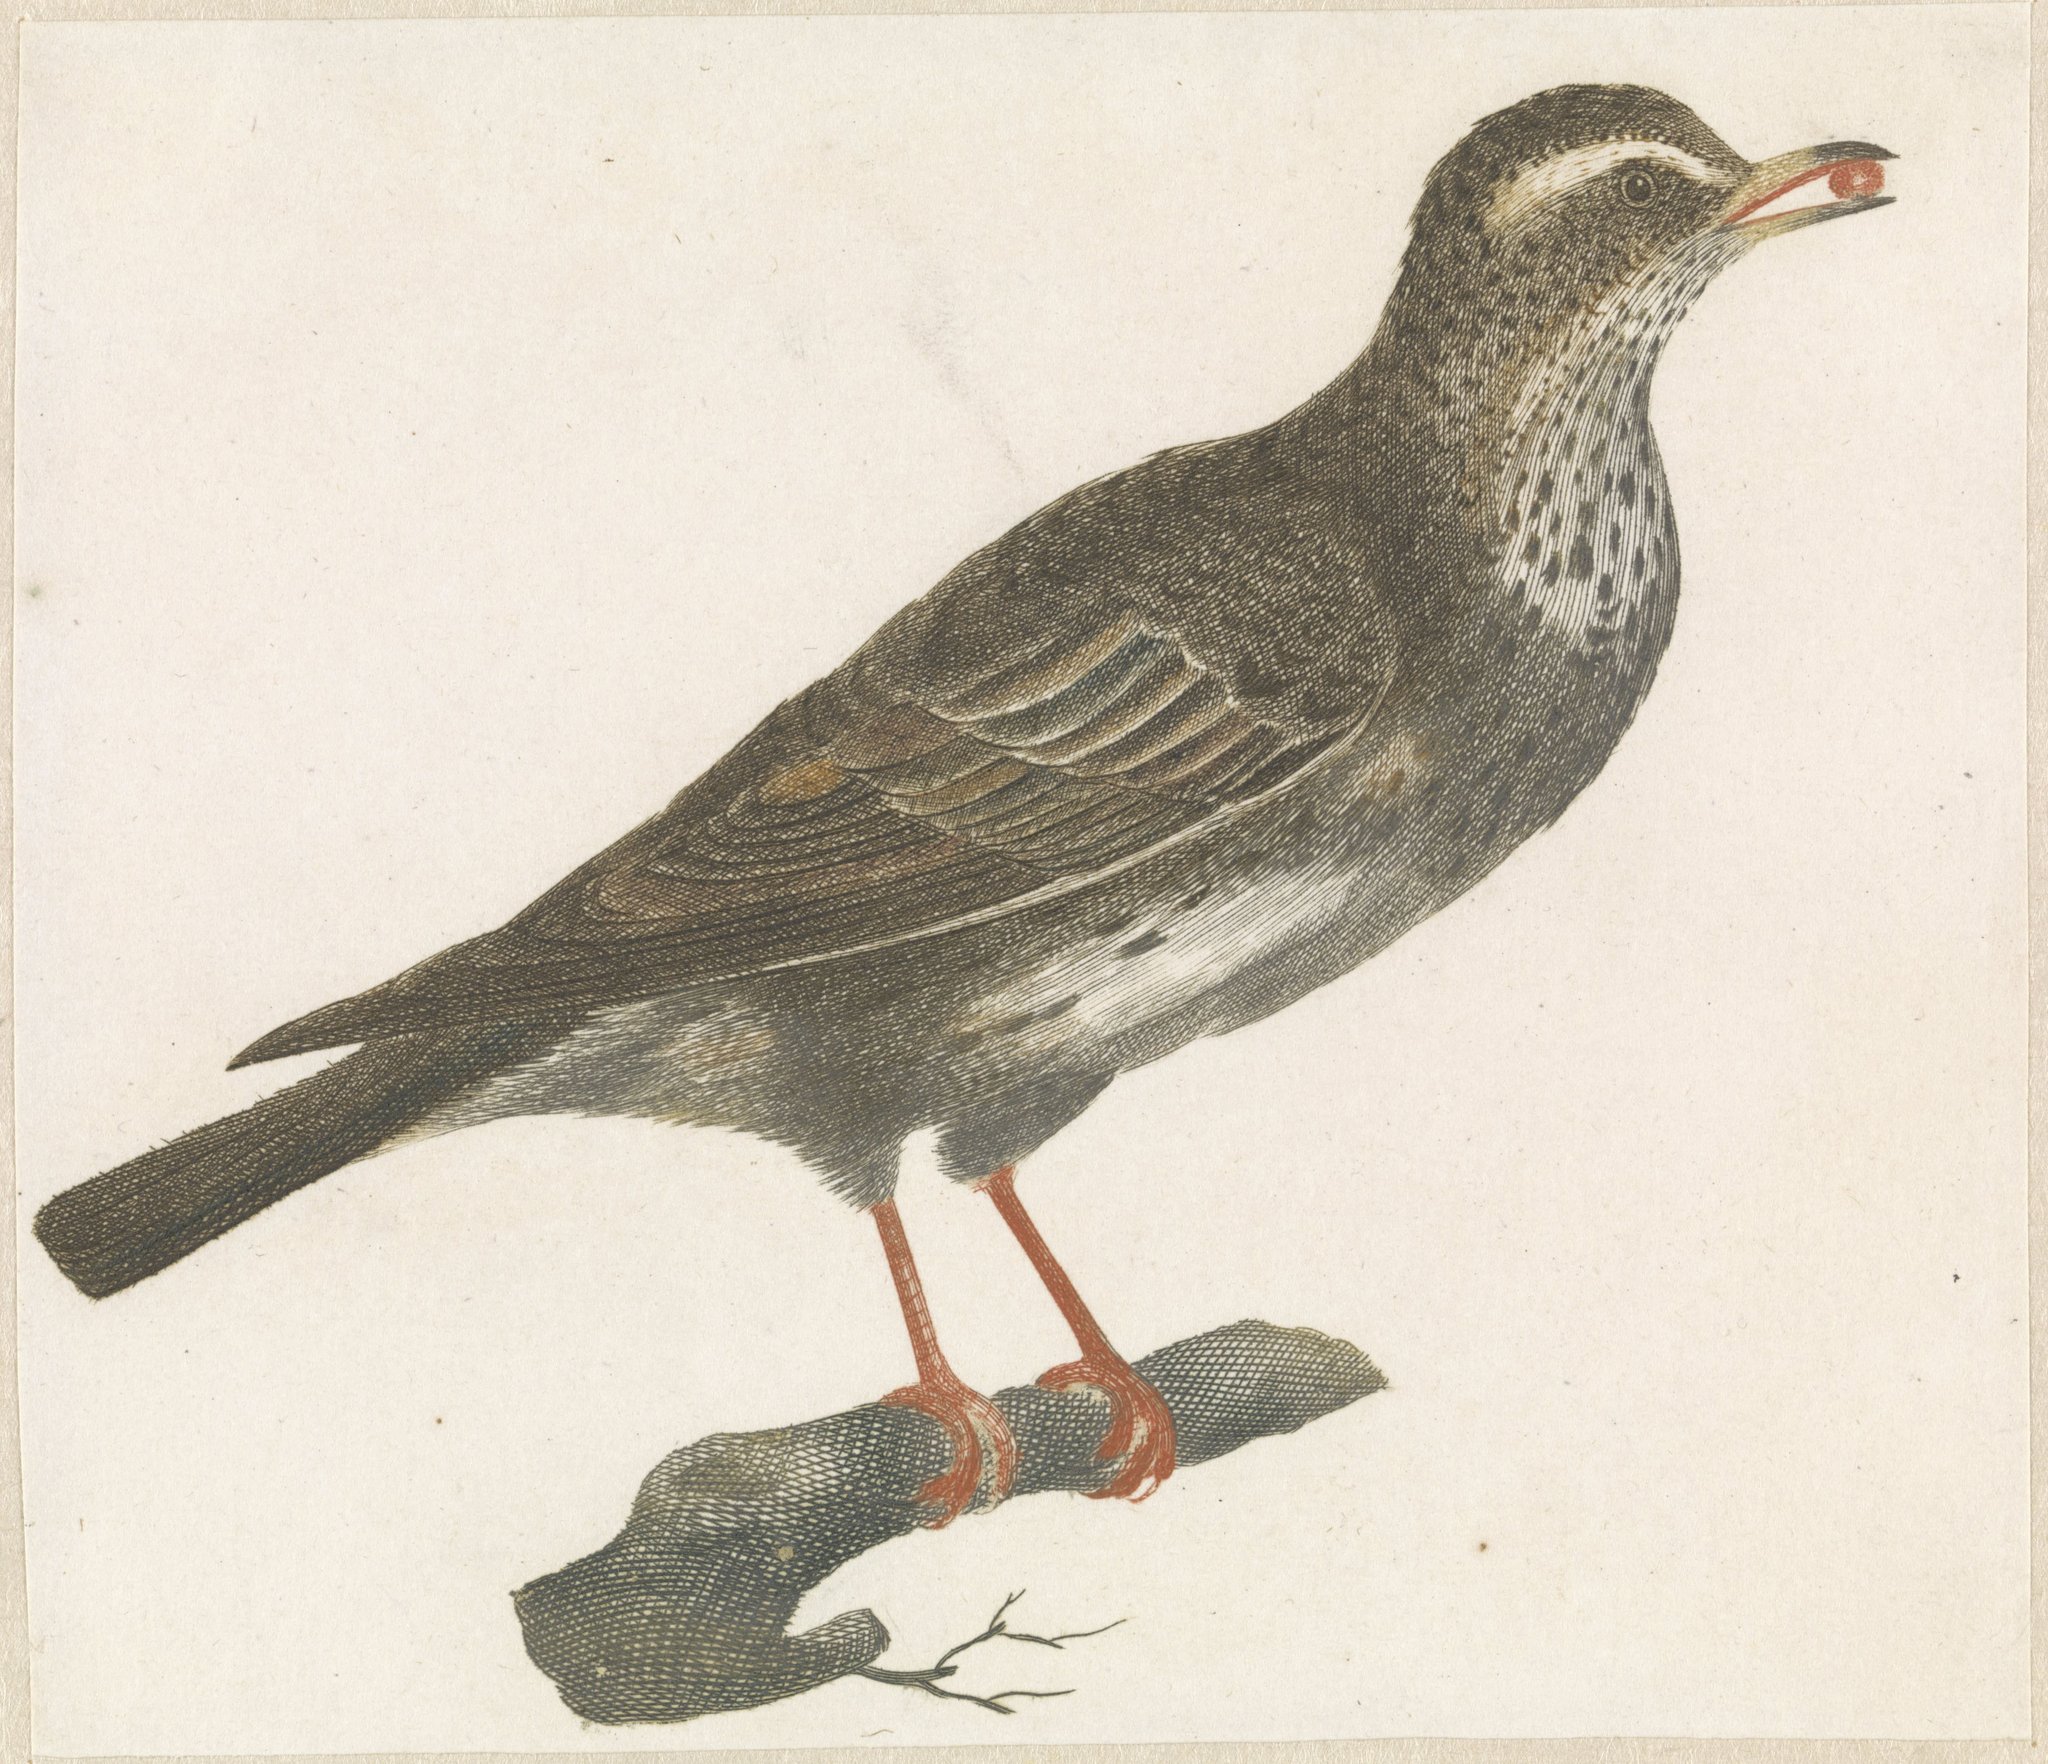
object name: print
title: Lijster met een bes in de bek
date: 1688-1698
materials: paper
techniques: printing, engraving, lithography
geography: netherlands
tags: song-birds: thrush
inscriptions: collector's mark: Lugt 2228, collector's mark: Lugt 2760